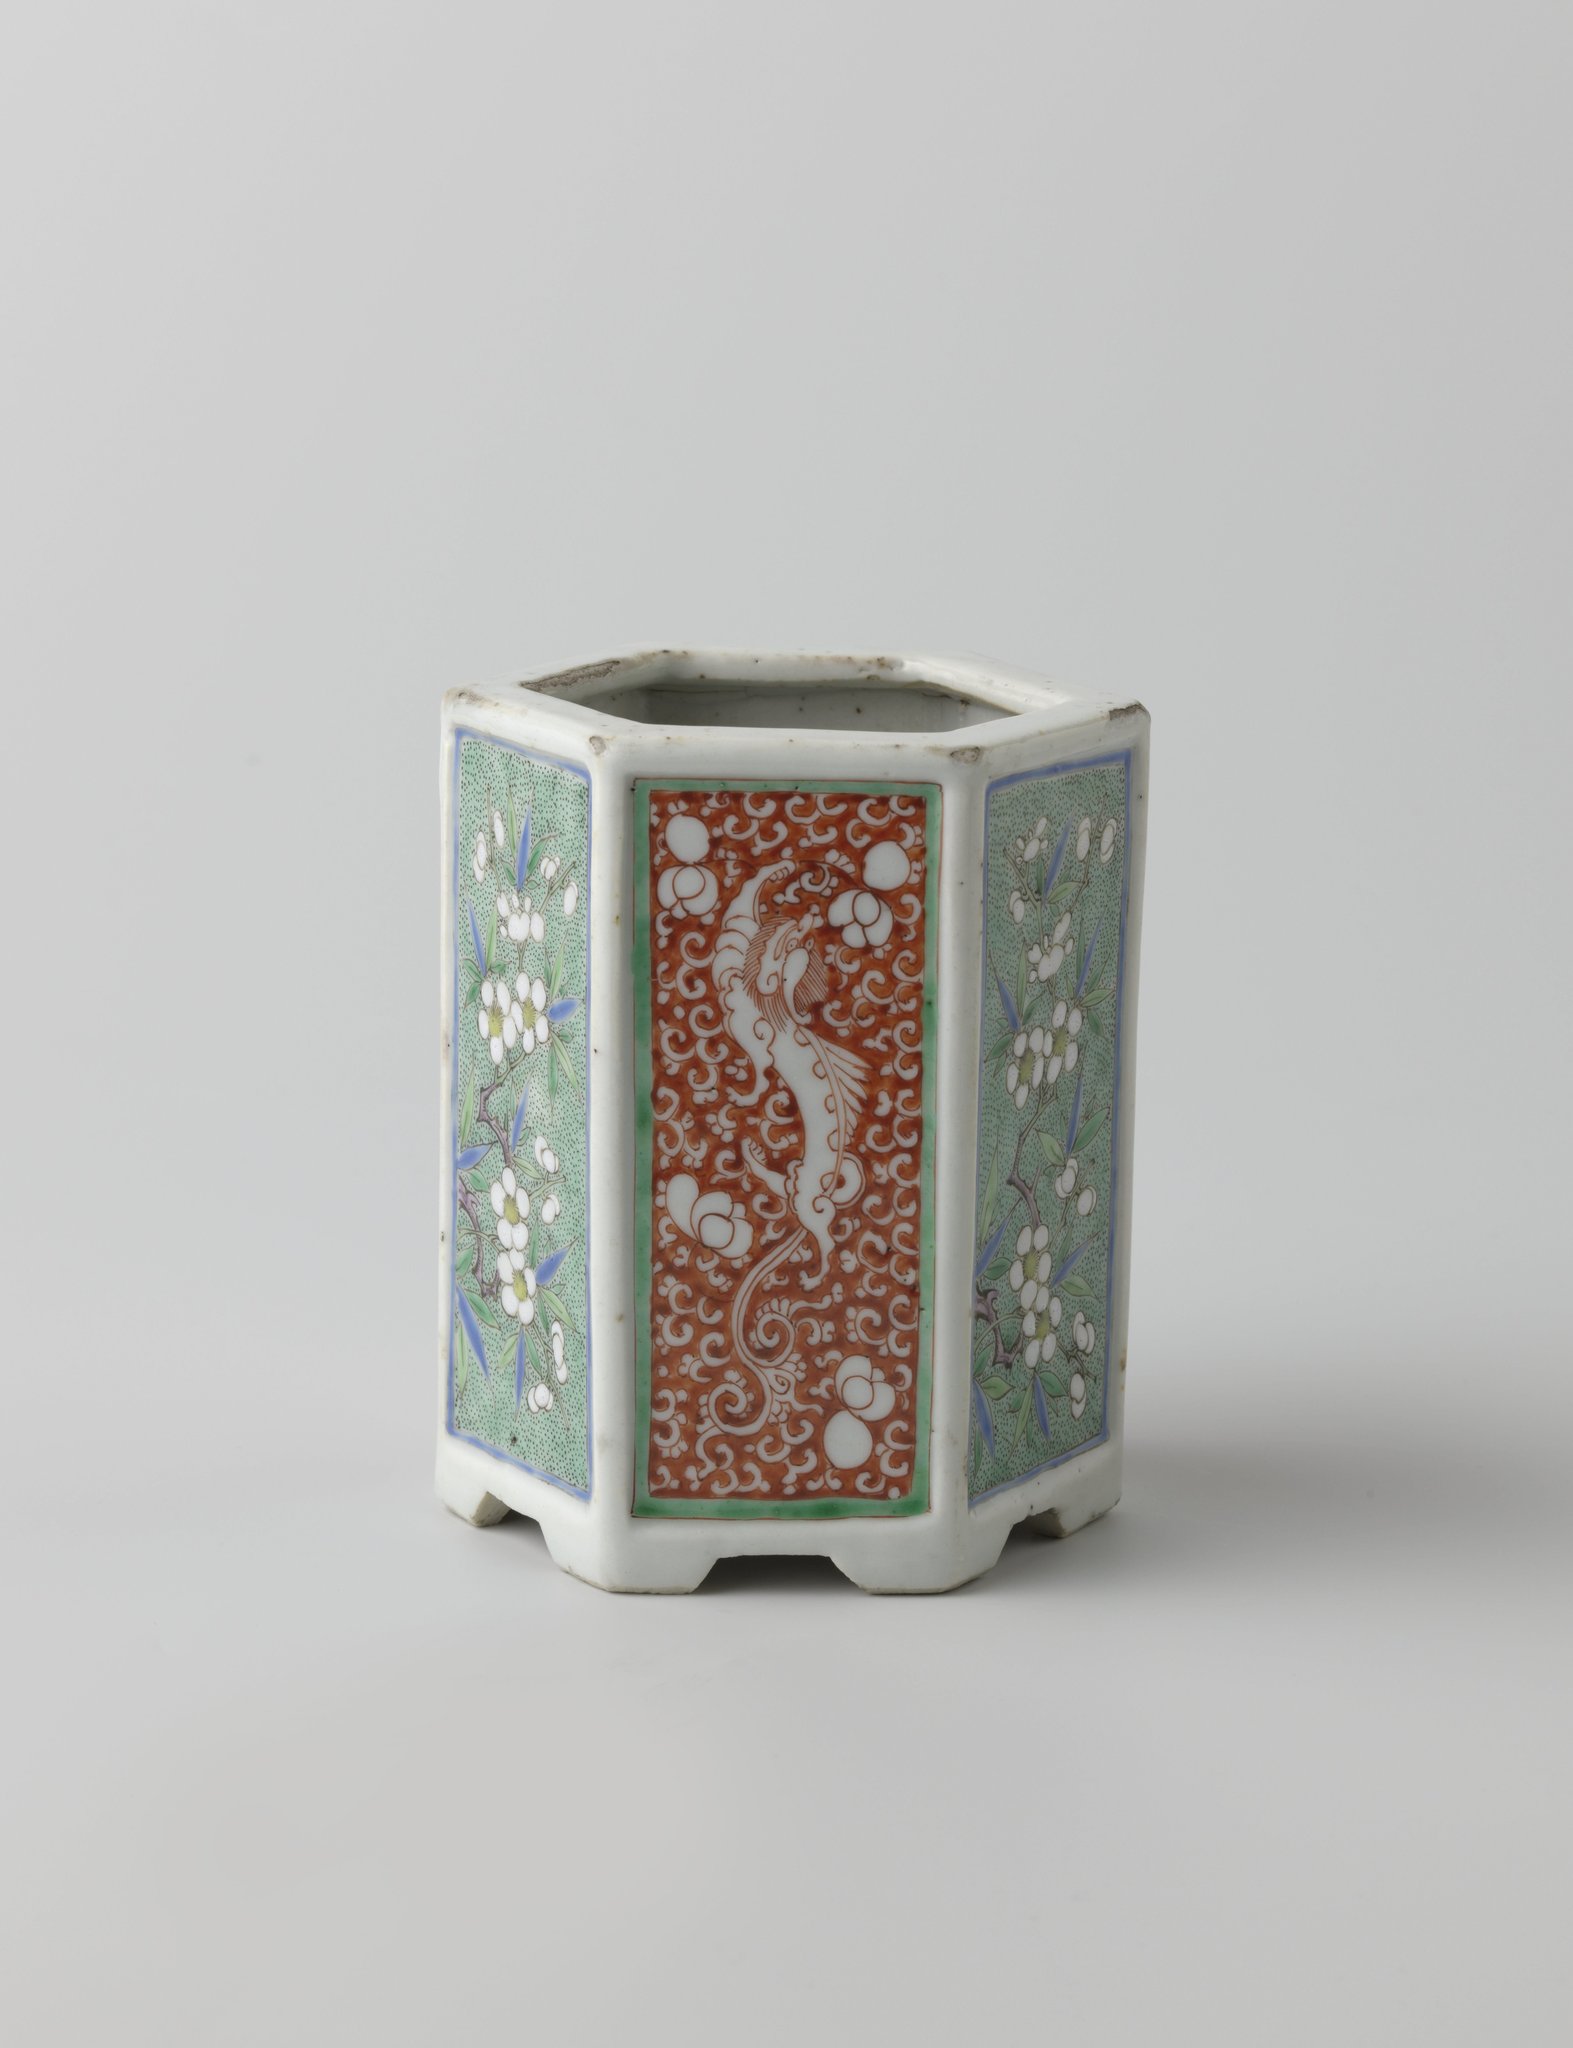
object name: penseelpot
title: Hexagonal brush pot with prunus sprays and dragons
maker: Anonymous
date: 1700-1724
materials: glaze, paint, porcelain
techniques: firing, forming, turning, vitrification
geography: china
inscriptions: label: ‘Huth 46/ 17/5/05’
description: Zeshoekige penseelpot van porselein, beschilderd op het glazuur in blauw, rood, groen, geel, aubergine en zwart. De wanden gemodelleerd in verzonken vakken met afwisselend een prunustak tegen een zwart gespikkelde groene grond en een draak met krulwerk in reserve in een rode grond. Oud label op de onderzijde met 'Huth 46 17/5/05'. Famille verte.